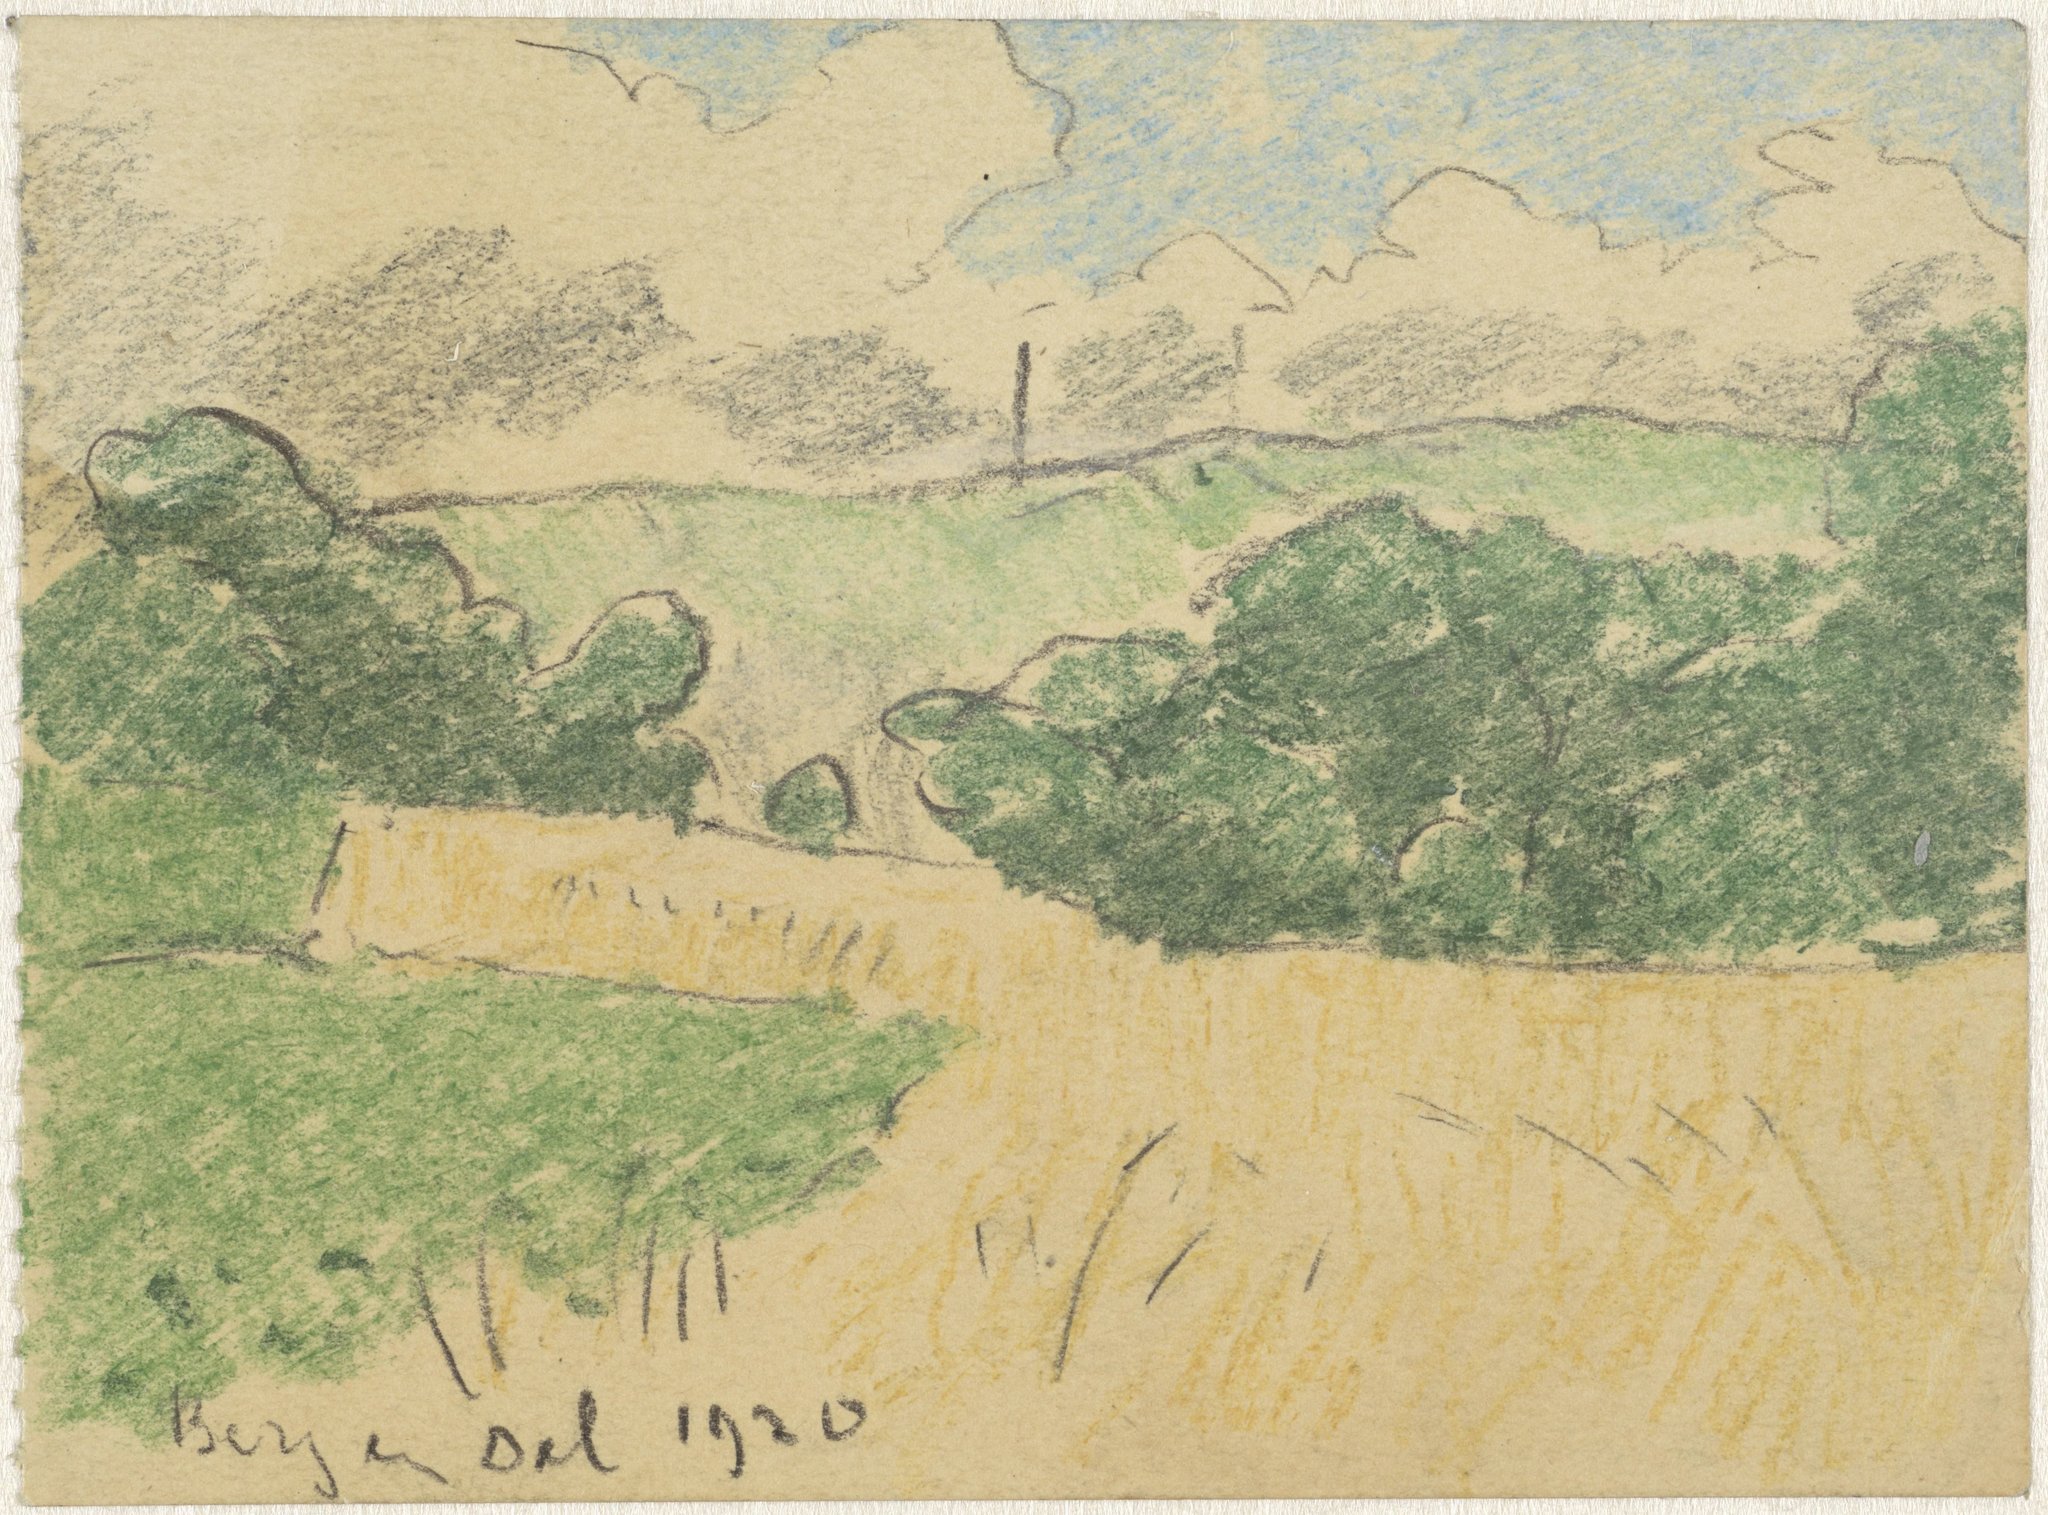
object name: drawing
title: Korenakker tussen bomen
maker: adolf le comte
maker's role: draughtsman, painter, print maker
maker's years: 1850-1921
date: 1920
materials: chalk, paper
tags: low hill country